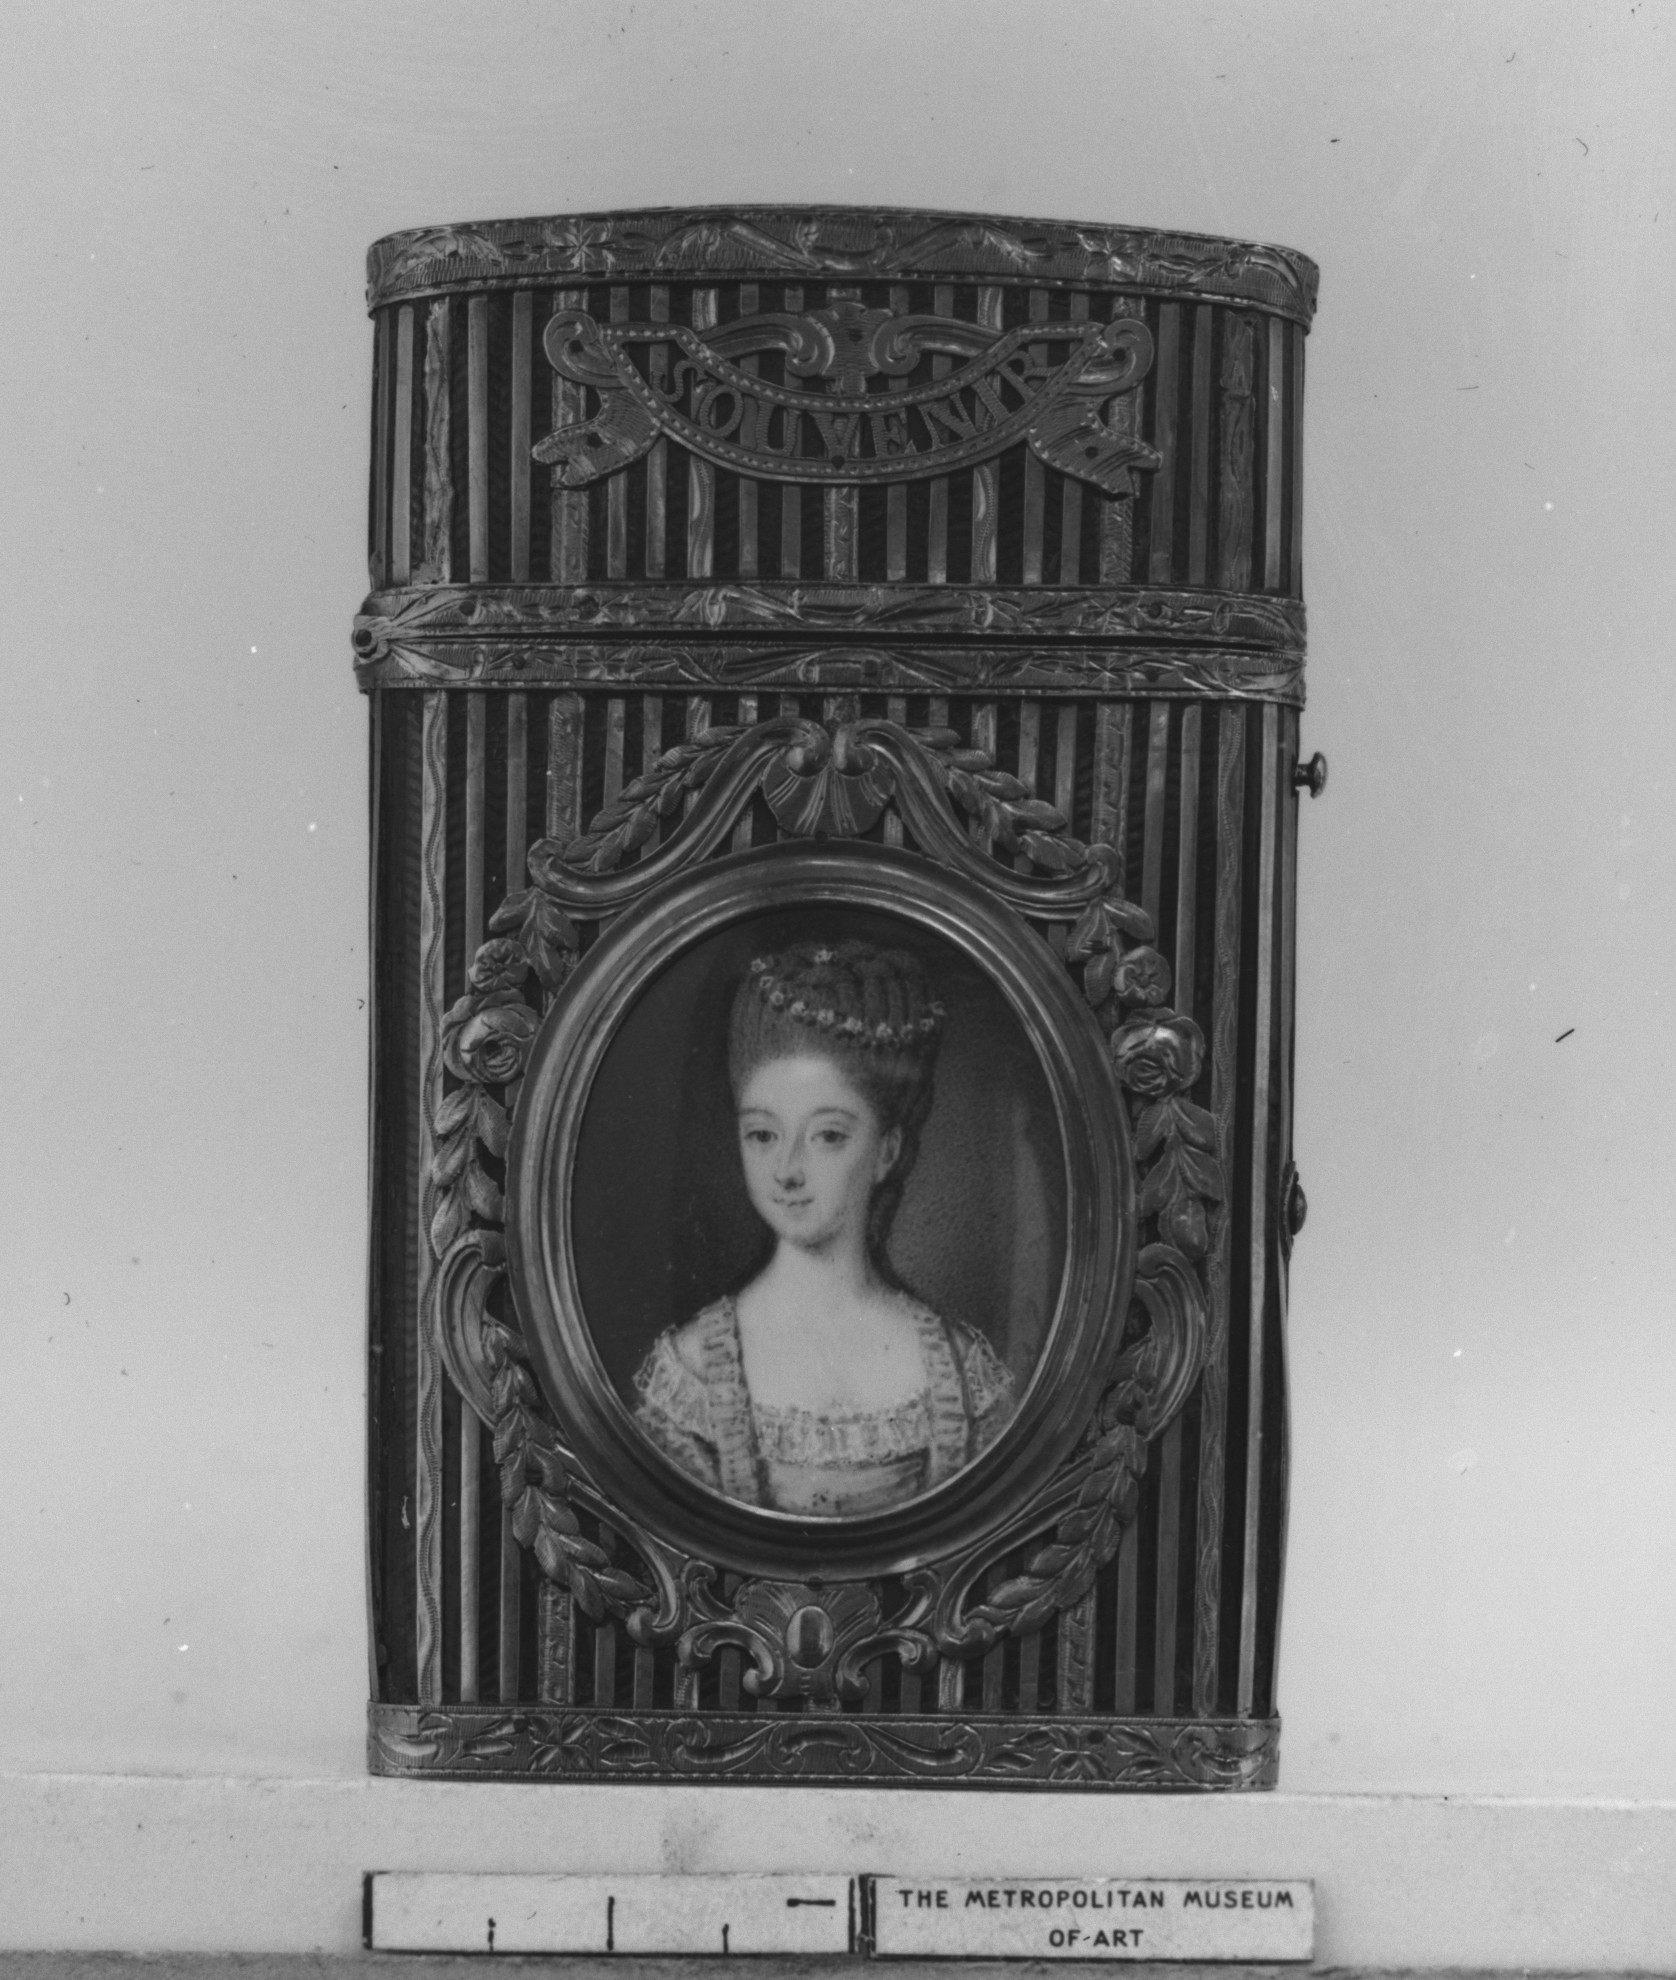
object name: souvenir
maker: henri jean douté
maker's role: maker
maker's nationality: french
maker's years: 1737-1837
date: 1773-1774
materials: enamel, gold, ivory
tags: portraits,women